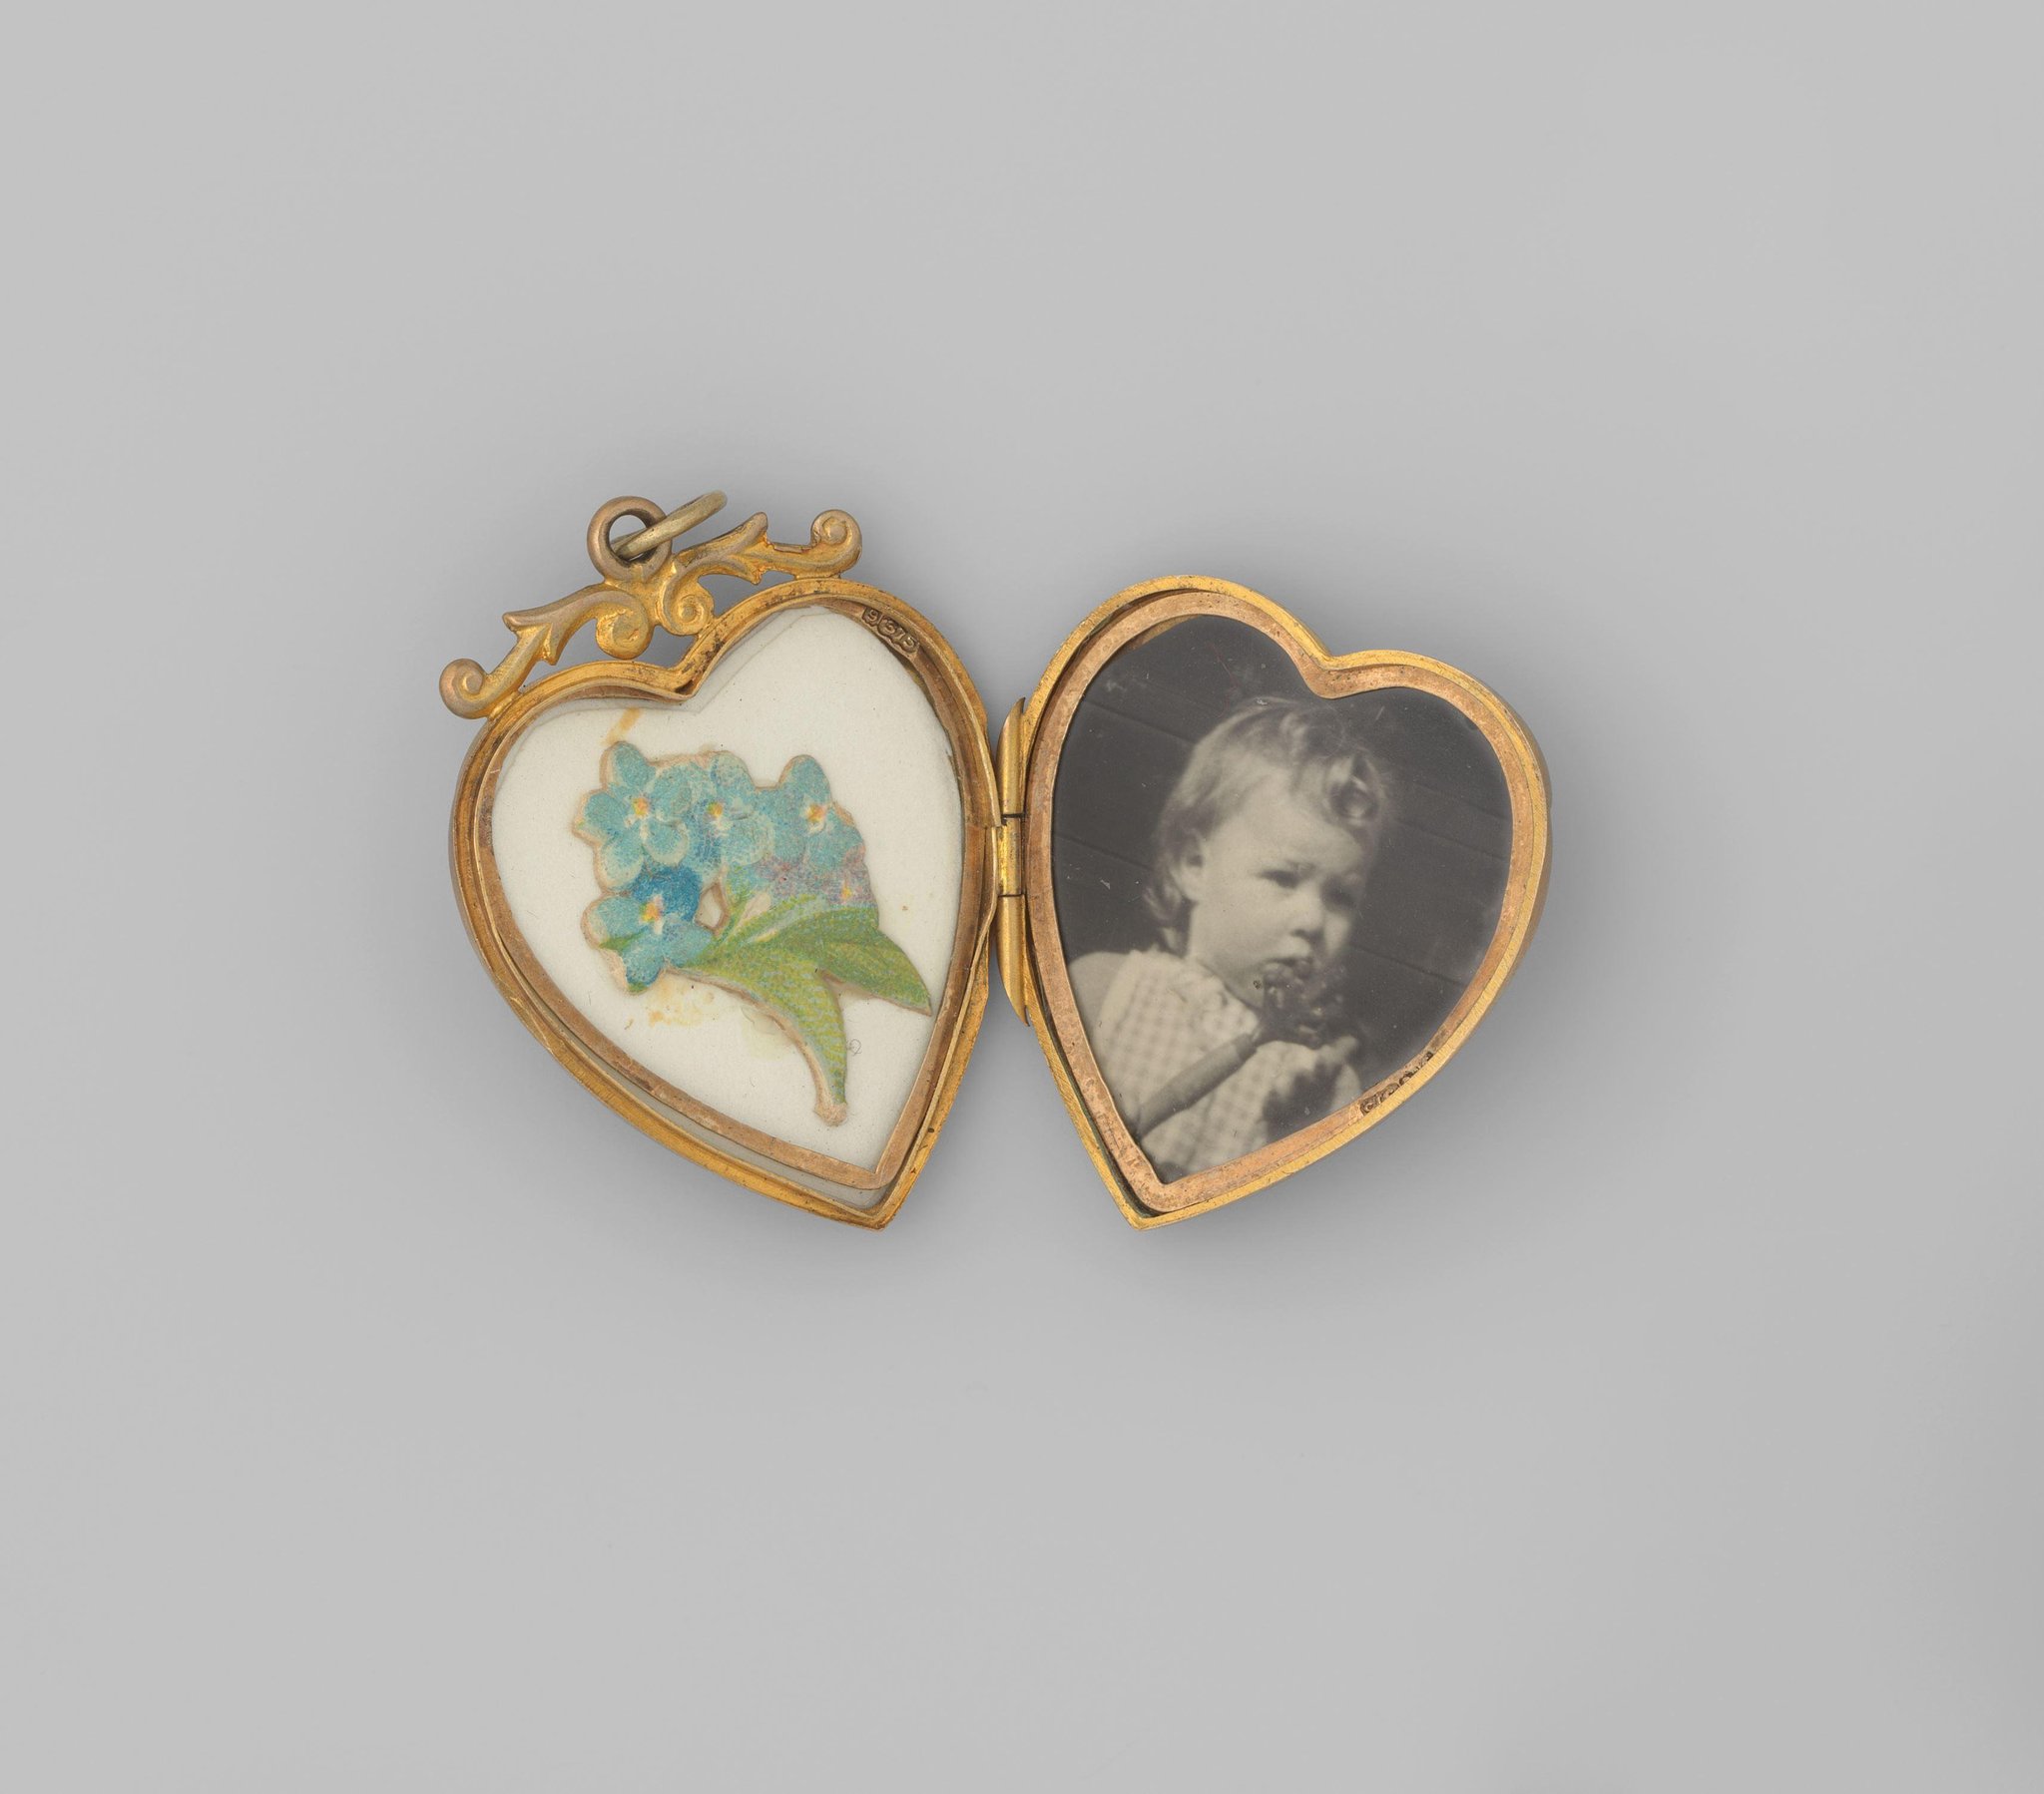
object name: photograph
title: Portret van een onbekend meisje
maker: Anonymous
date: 1900-1930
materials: paper, celluloid, metal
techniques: gelatin silver print, gilding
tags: historical persons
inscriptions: inscription: ‘mw Belly[?]’